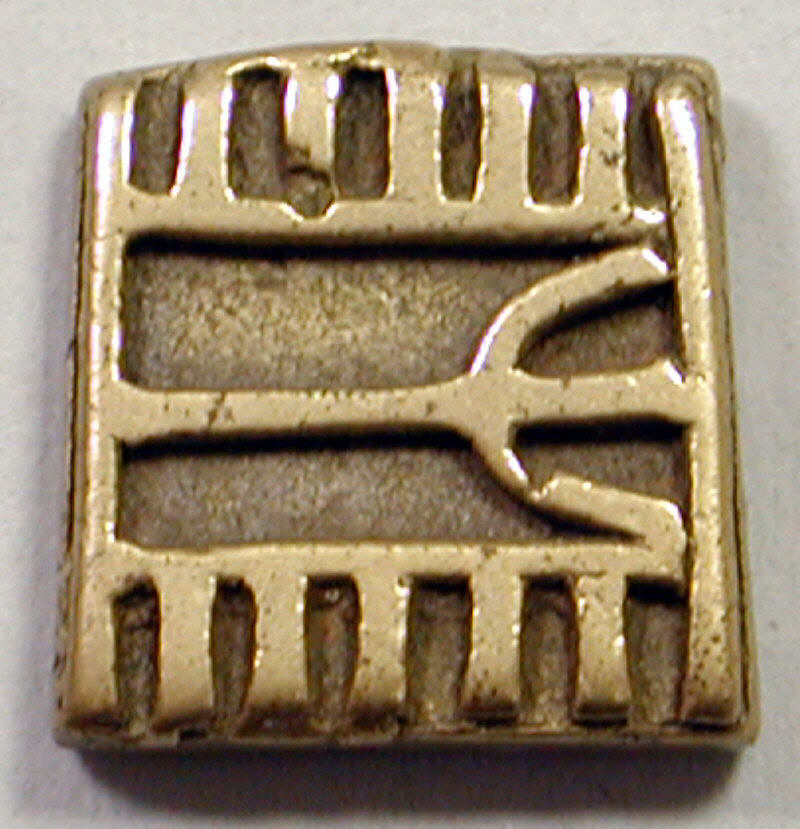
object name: weight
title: Gold Weight: Geometric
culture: akan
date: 1701-1900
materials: brass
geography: ghana